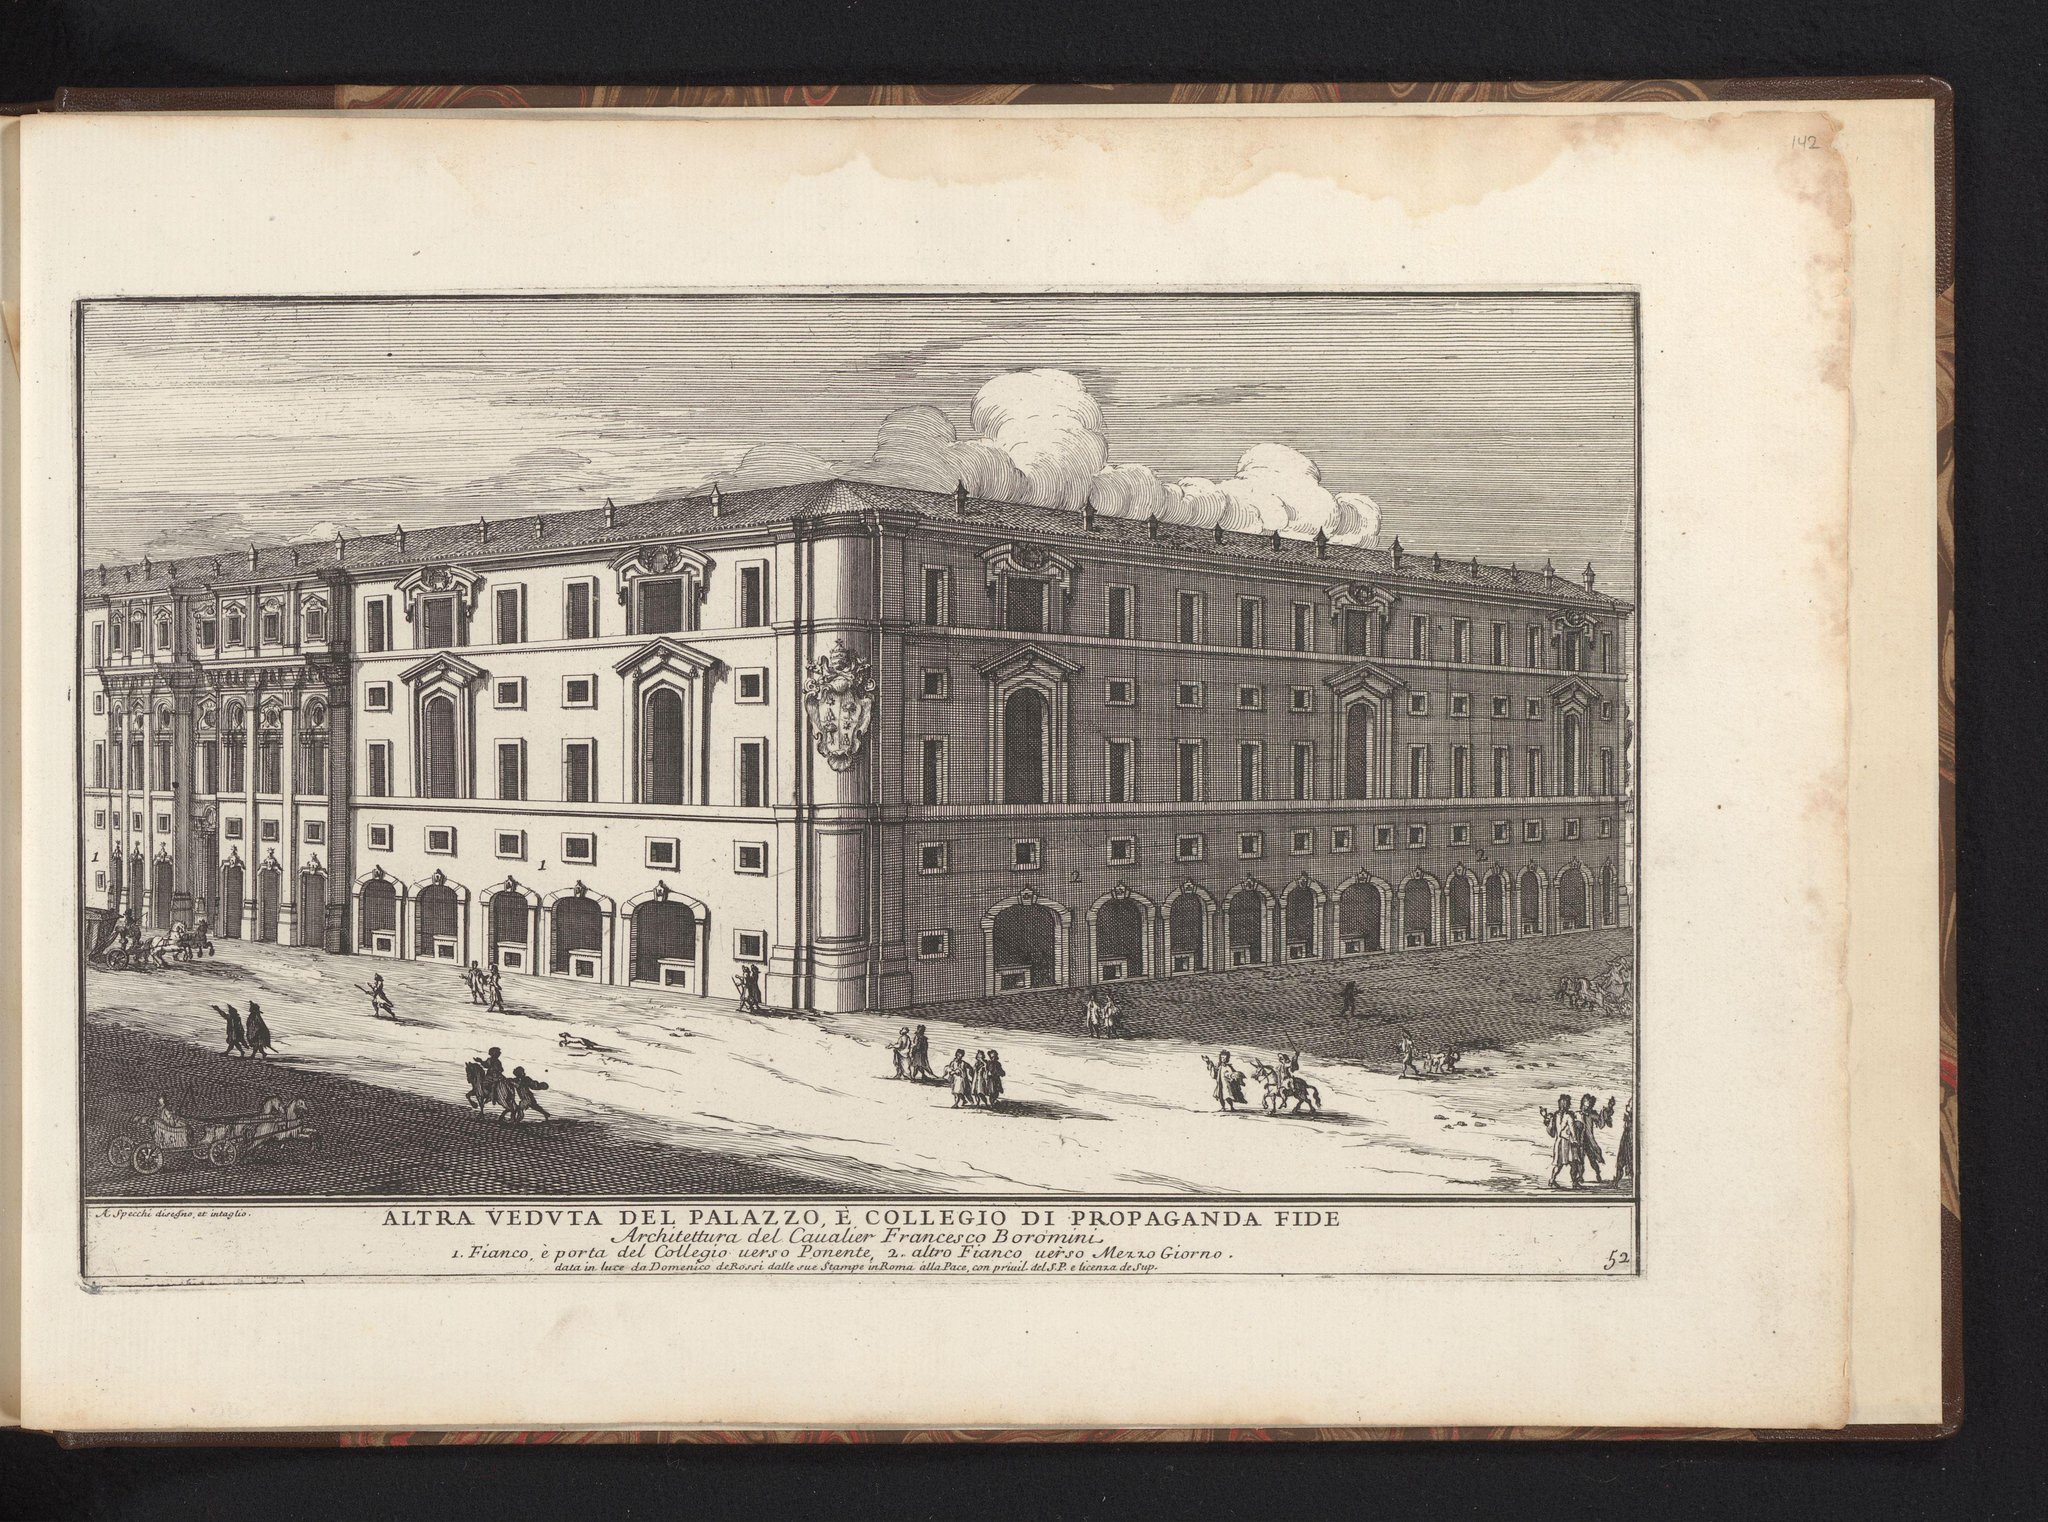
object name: album leaf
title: Collegio de Propaganda Fide te Rome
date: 1699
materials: paper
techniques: etching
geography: italy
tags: city-view, and landscape with man-made constructions, hôtel, i.e. small palace in city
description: Deze prent maakt deel uit van een reeks van 52 prenten met voorstellingen van paleizen in Rome. Samen met vier andere reeksen vormt het de grote reeks: 'Il nuovo teatro di Roma moderna'.